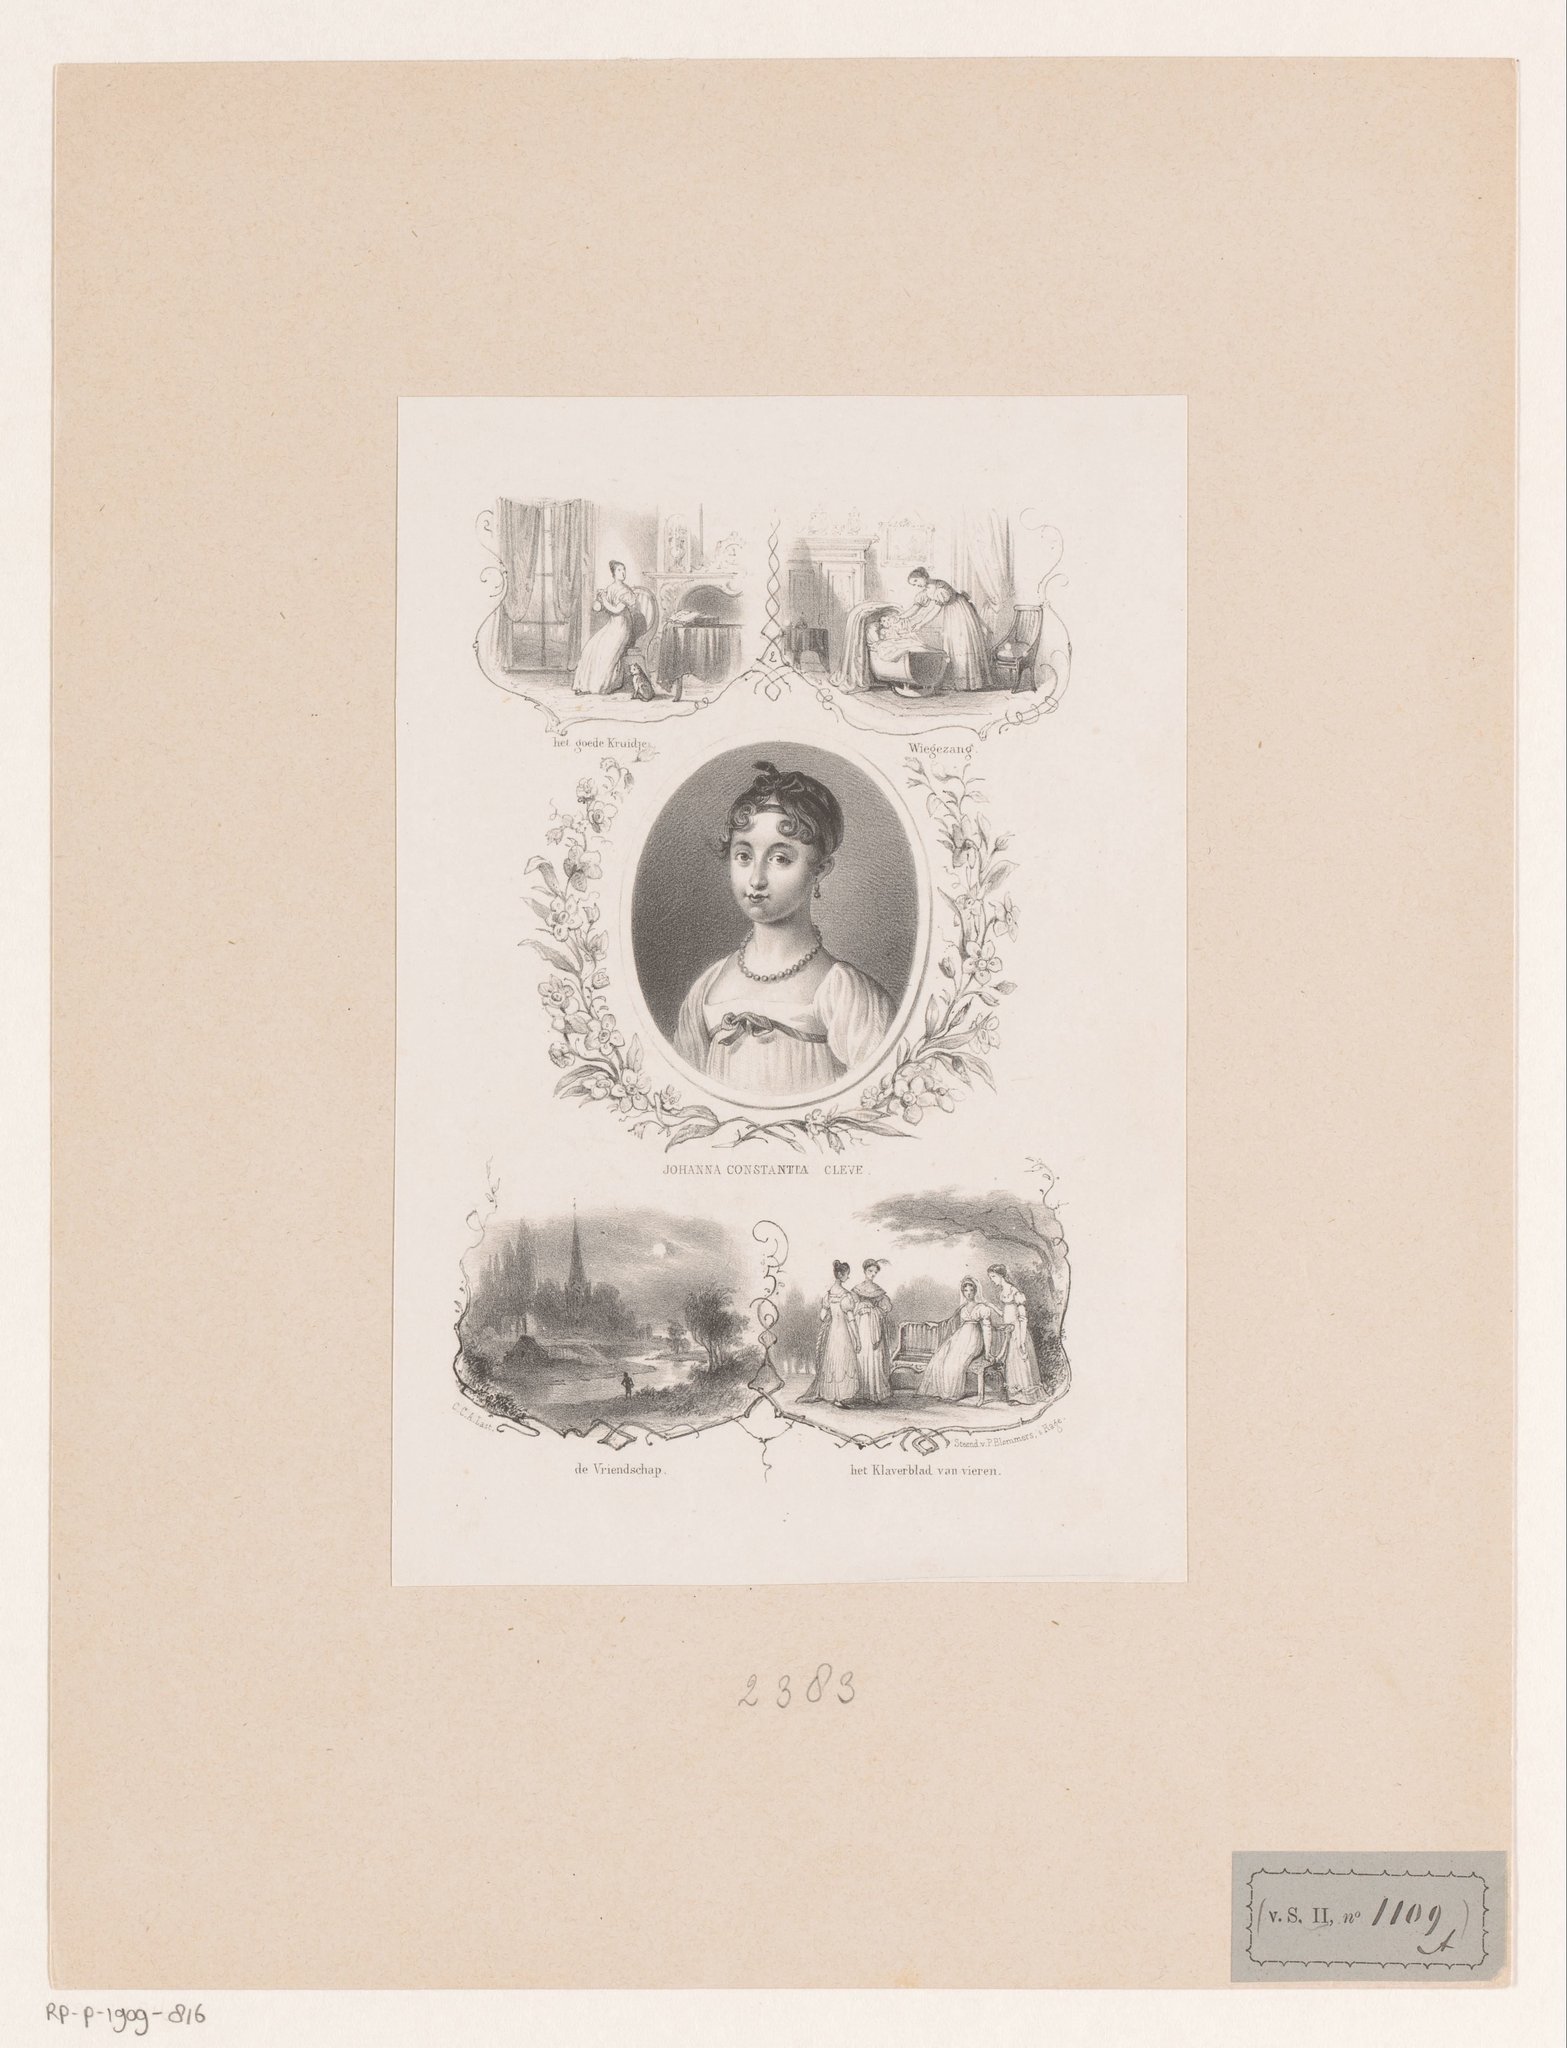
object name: print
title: Portret van Johanna Constantia Cleve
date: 1842-1887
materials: paper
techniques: lithograph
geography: netherlands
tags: leiden, historical persons - bb - woman (+ (full) bust portrait), cradle, crib, writer, poet, author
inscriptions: collector's mark: Lugt 2228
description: Het portret van de dichteres is omkranst door bloemen. In de hoeken afbeeldingen die verwijzen naar haar gedichten. De titels 'Het goede kruidje' en 'Wiegezang' komen uit de bundel 'Lentebloemen'. Het gedicht 'Het klaverblad van vieren' verscheen postuum in 1825 in de bundel 'Muzen-Almanak'.